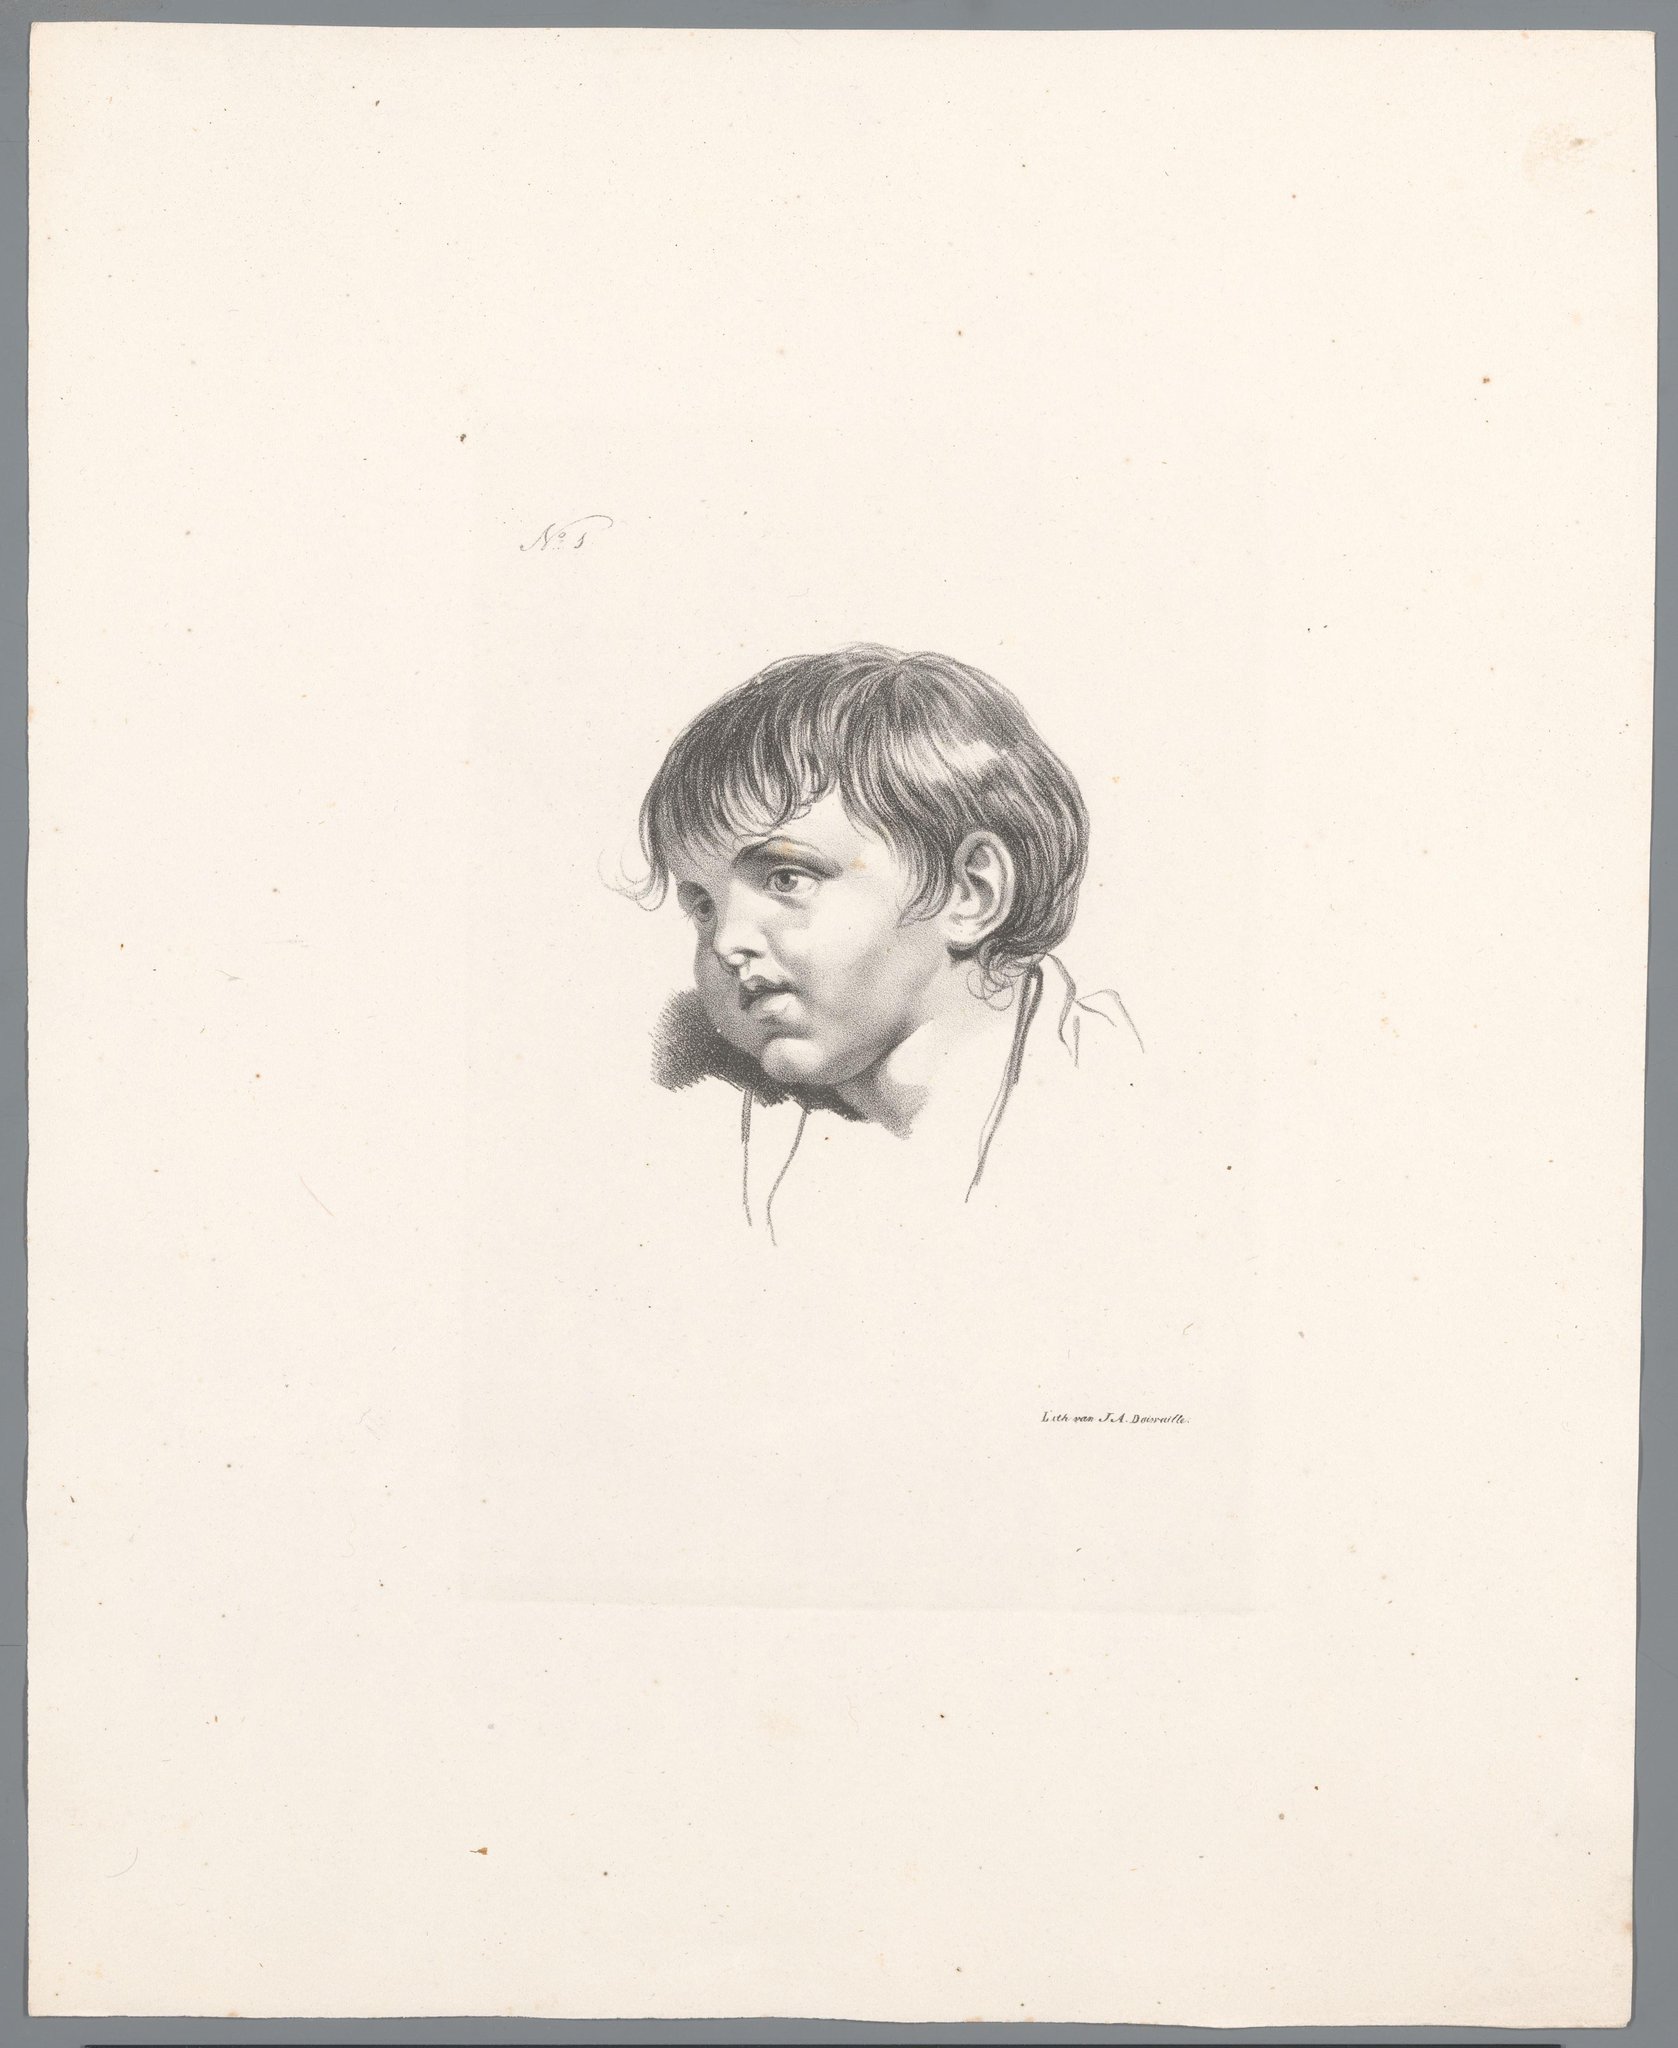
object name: print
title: Kinderkopje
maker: jean augustin daiwaille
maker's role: draughtsman, print maker, printer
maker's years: 1786-1850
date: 1820-1830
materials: paper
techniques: lithograph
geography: amsterdam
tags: child between toddler and youth (of undetermined sex)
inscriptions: collector's mark: Lugt 2228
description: 'Hartstochten na J.B. Greuze' bestaat uit twee of drie genummerde reeksen. (Sommige nummers komen drie keer voor op drie verschillende afbeeldingen.) Binnen deze omslag bevinden zich achttien verschillende afbeeldingen. Mogelijk heeft dit te maken met de twee momenten waarop Daiwaille de reeks uitgaf, ten tijden van zijn directeurschap aan de Rijksakademie in Amsterdam en daarna als zelfstandige. De omslag behoort waarschijnlijk bij een van deze twee series. Zie Marres-Schretlen in het Bulletin van het Rijksmuseum.